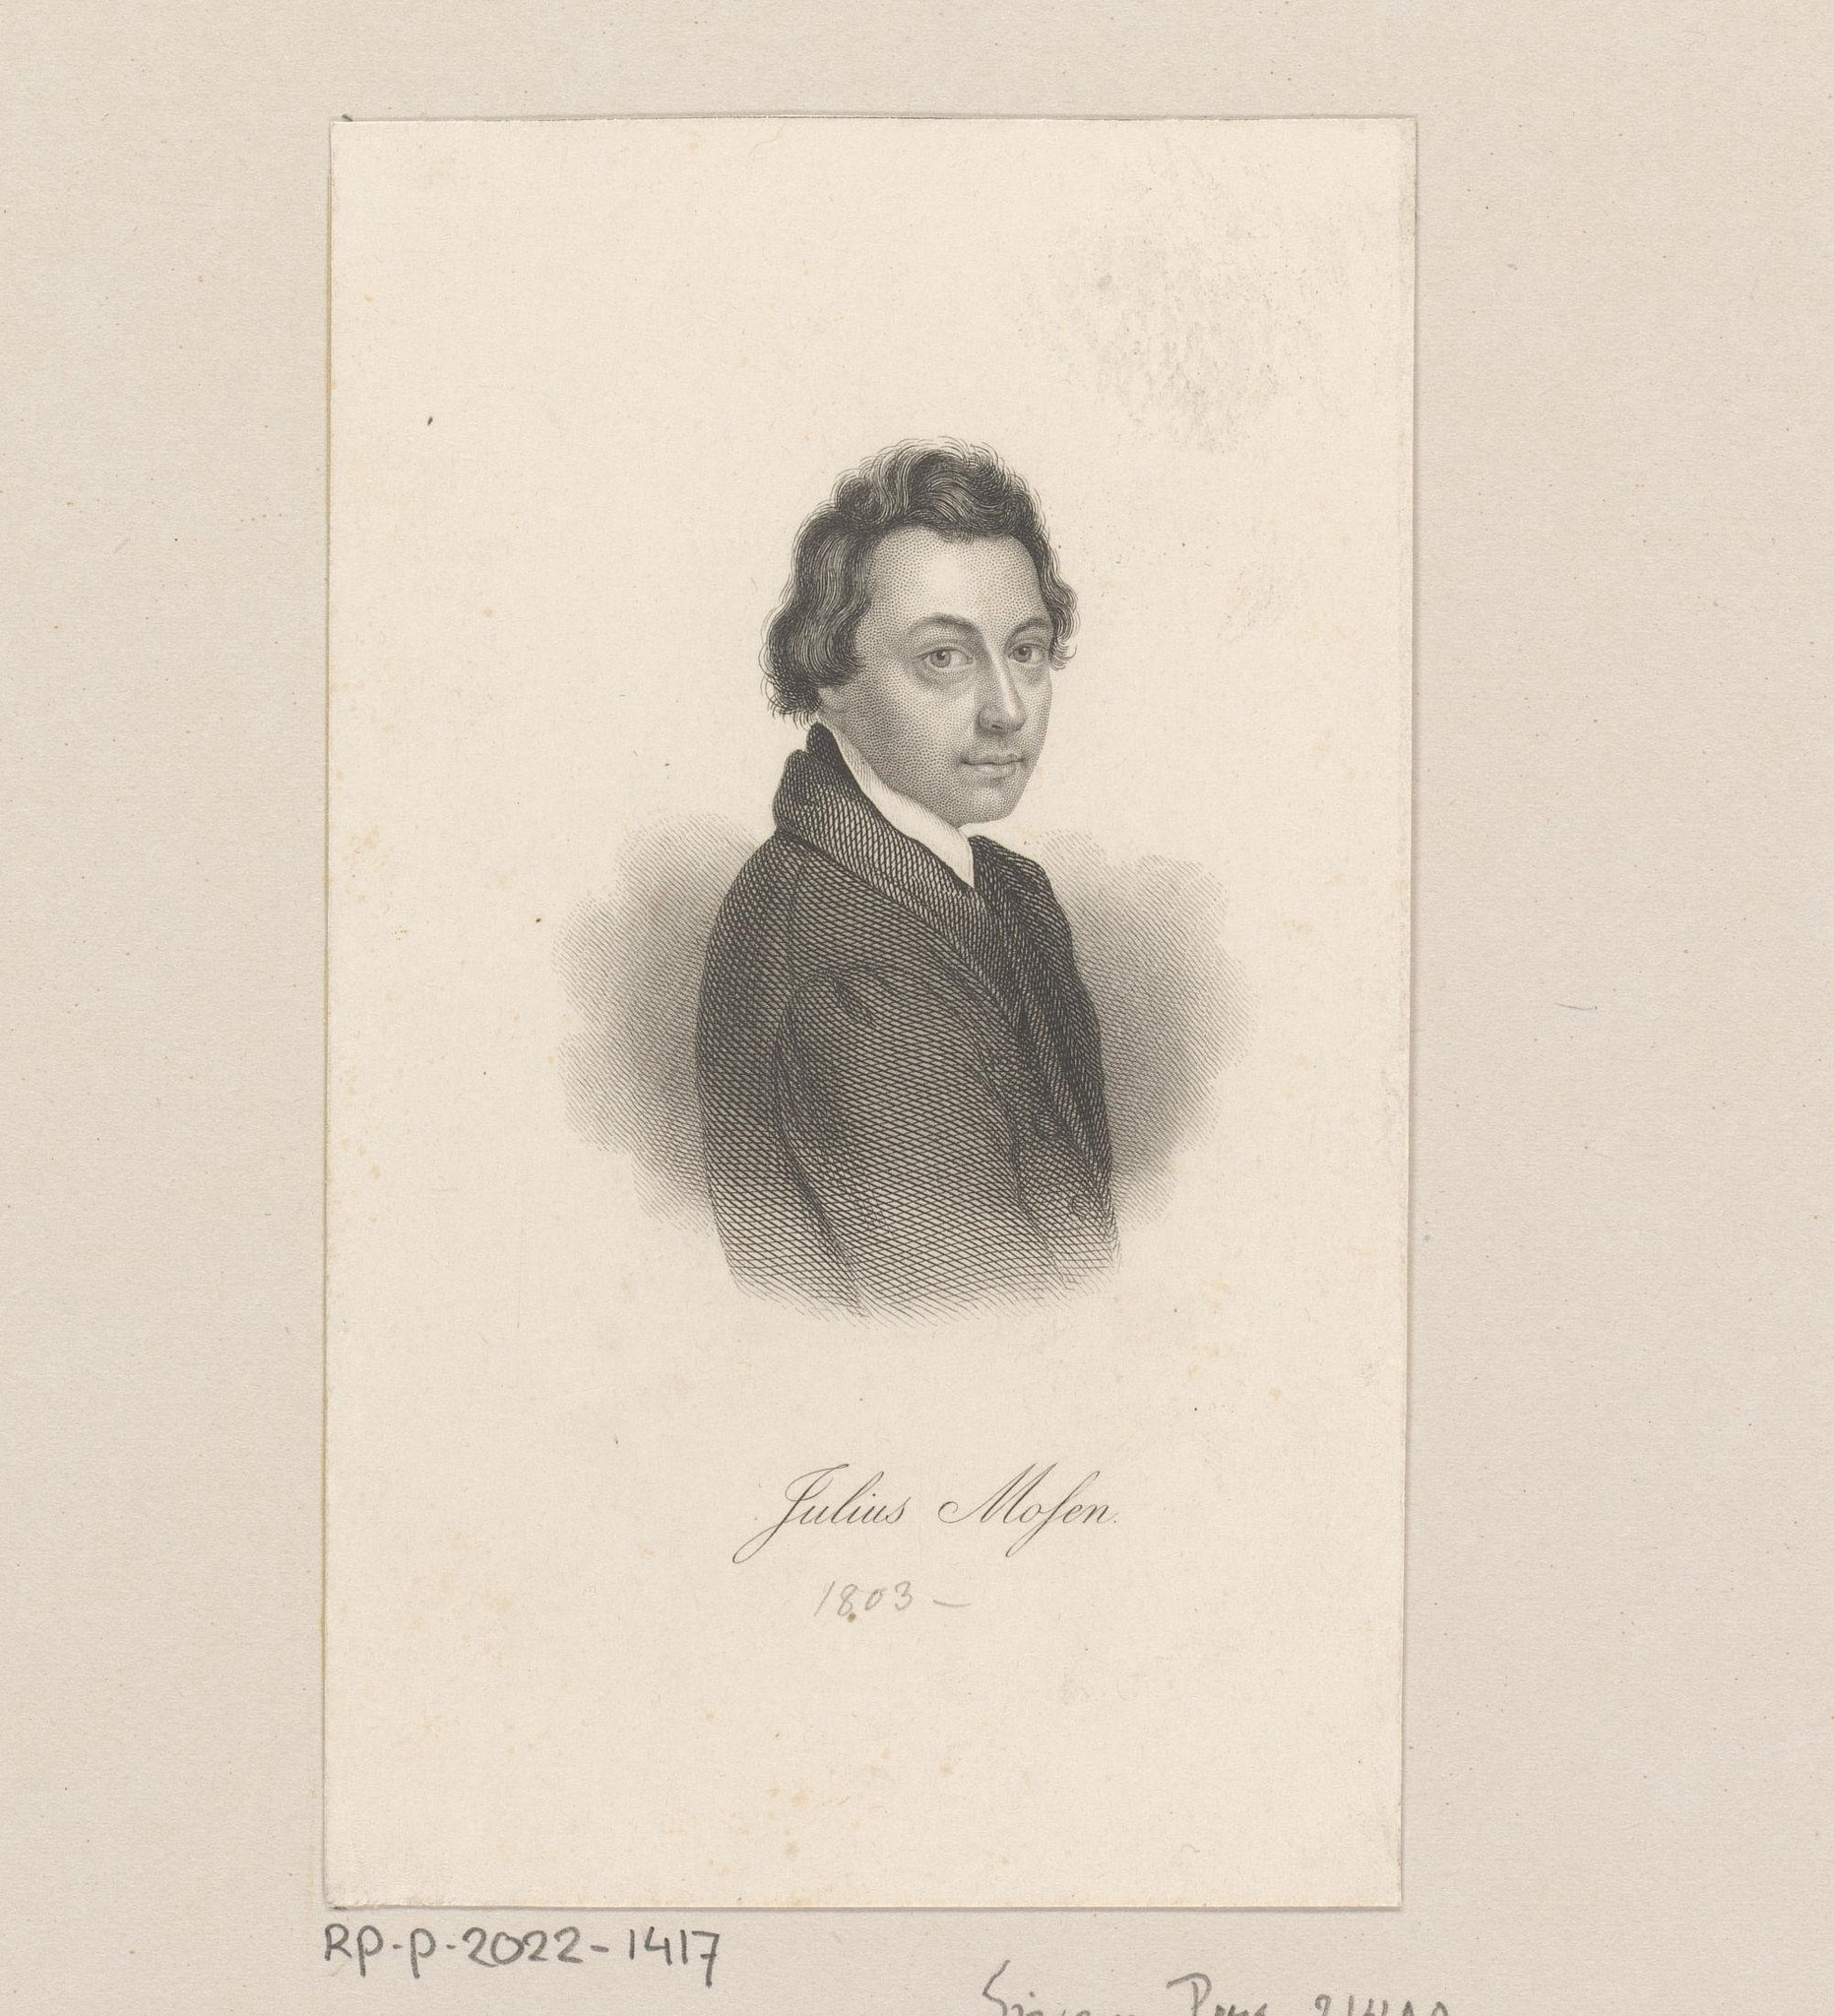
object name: print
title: Julius Mosen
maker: Anonymous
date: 1830-1900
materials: paper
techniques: engraving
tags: portrait of a writer (+ arts of the stage), historical persons